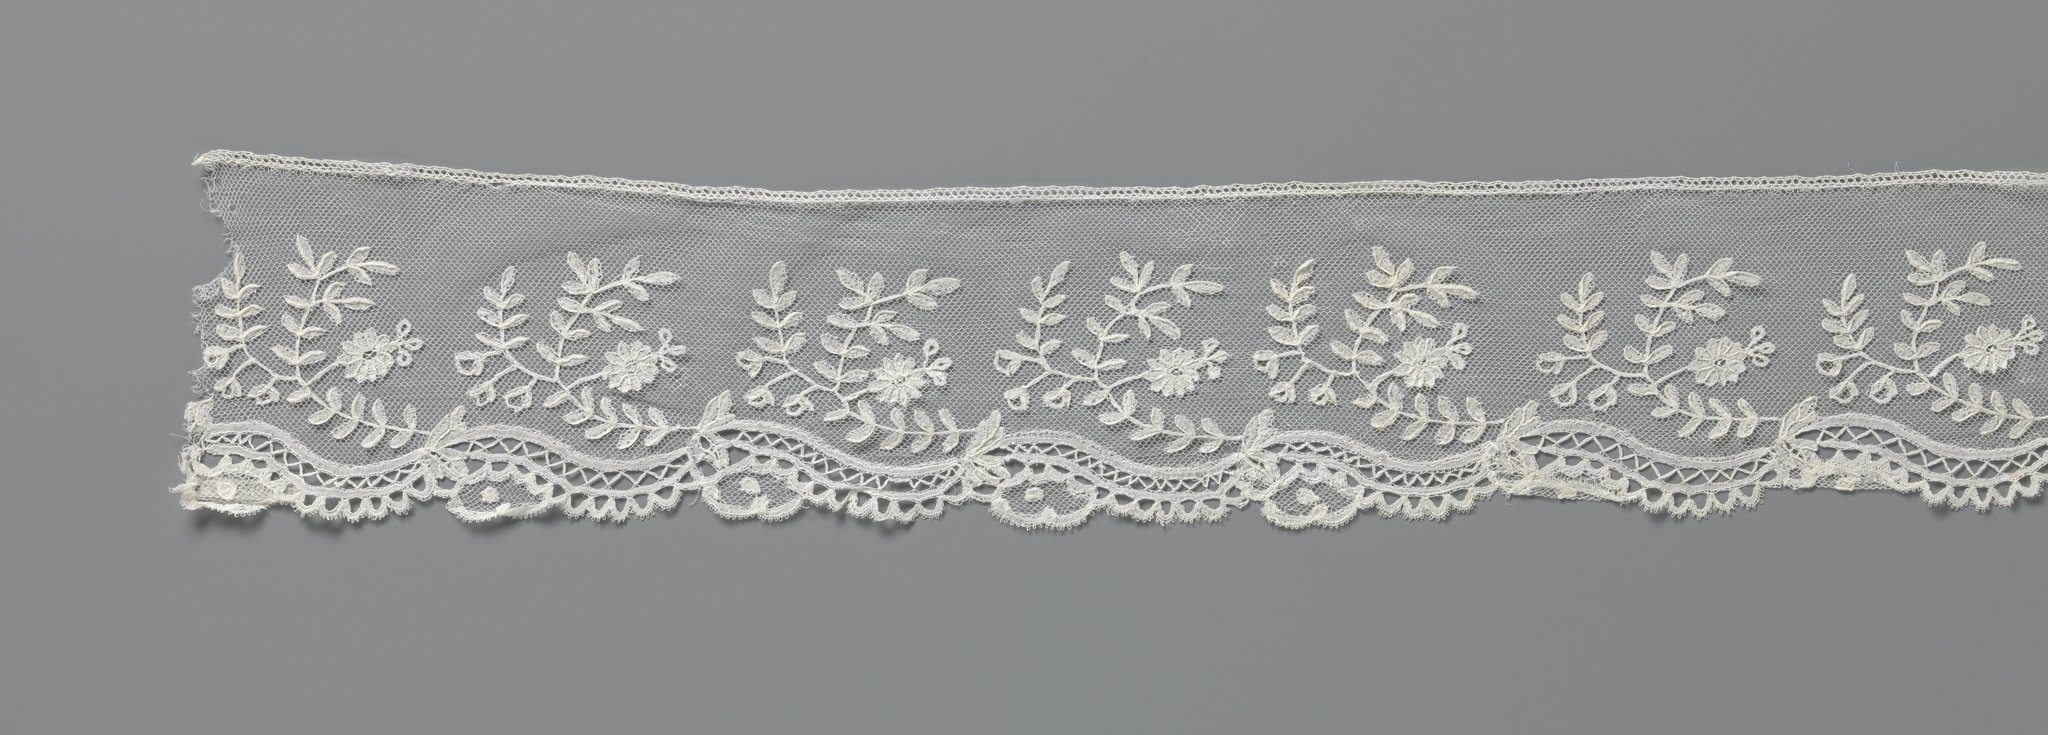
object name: strip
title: Strook applicatiekant met c-vormige bloemtak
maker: Anonymous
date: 1850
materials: cotton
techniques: lace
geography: brussels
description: Strook naturelkleurige Brusselse applicatiekant: kloskant met enkele naaldkantsiersteken geappliceerd op machinale tule. Het zich herhalende patroon bestaat uit c-vormige bloemtakken, die ontspringen uit een golvende onderrand met zigzagpatroon. Deze rand is afgezet met gepicoteerde boogjes, met onder elke golftop een rocaille-achtig motief met een stip in het centrum. De motieven zijn gemaakt in linnenslag met opengewerkte randjes en voorzien van reliëfcontouren. De bovenzijde is afgezet met een apart geklost bandje.